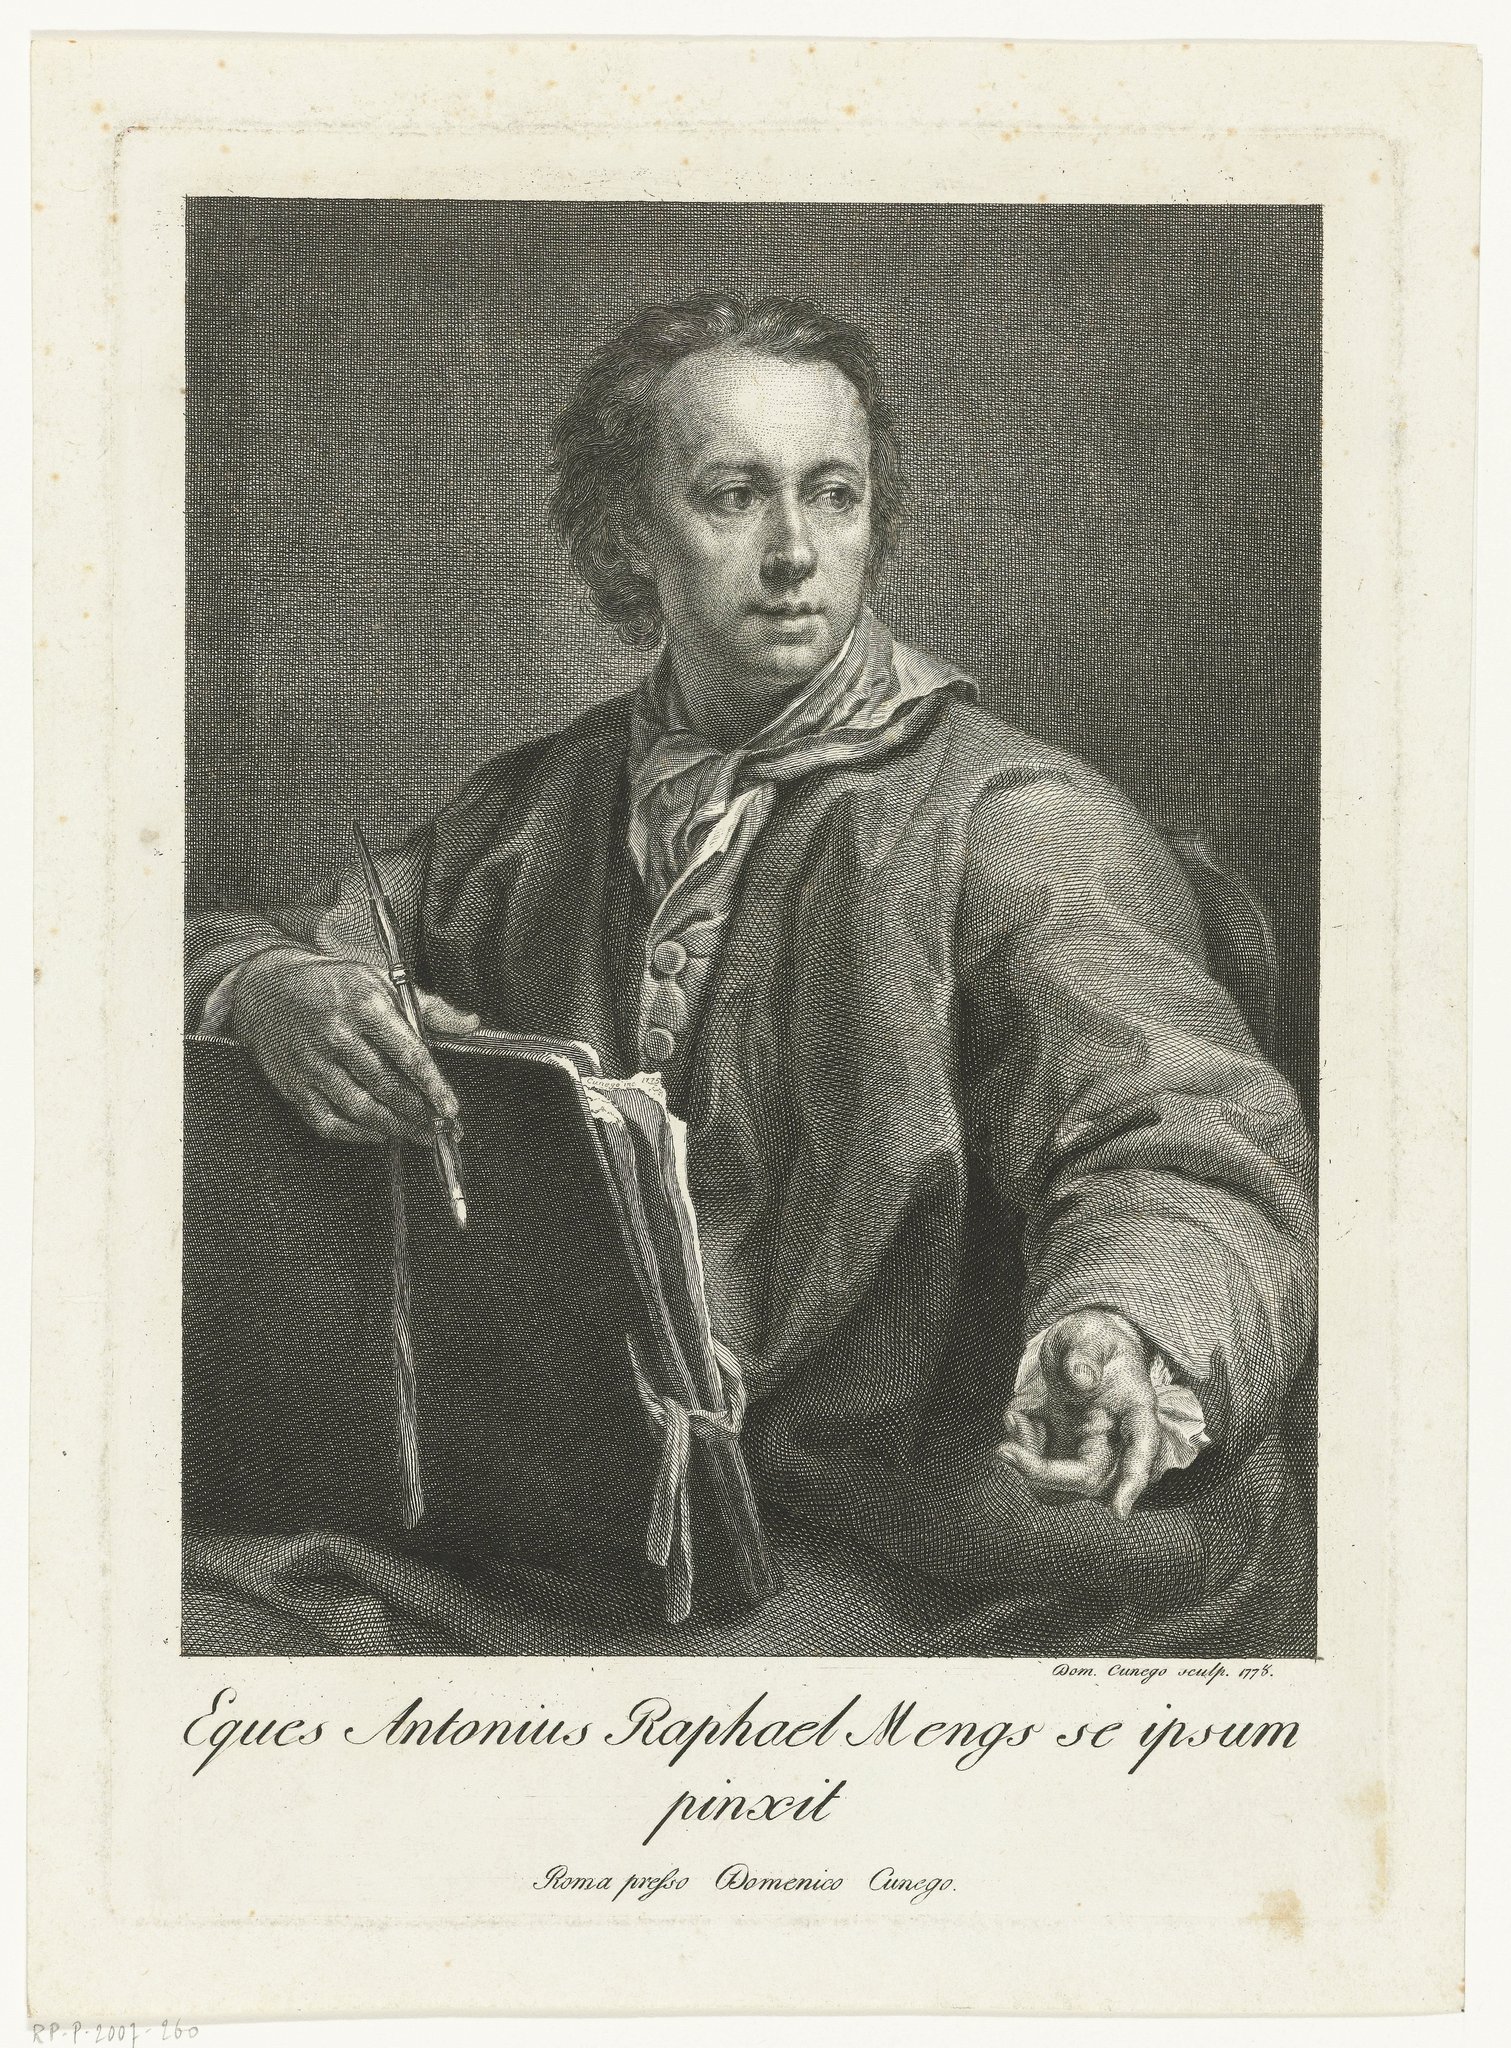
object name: print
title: Portret van kunstenaar Anton Raphaël Mengs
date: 1775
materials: paper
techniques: etching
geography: rome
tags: rome, draughtsman, anton raphael mengs, historical persons, portrait, self-portrait of painter, tools, implements of draughtsman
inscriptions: collector's mark: Lugt 2228, collector's mark: Lugt 2760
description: Naar zelfportret door Mengs in de Hermitage te St. Petersburg.